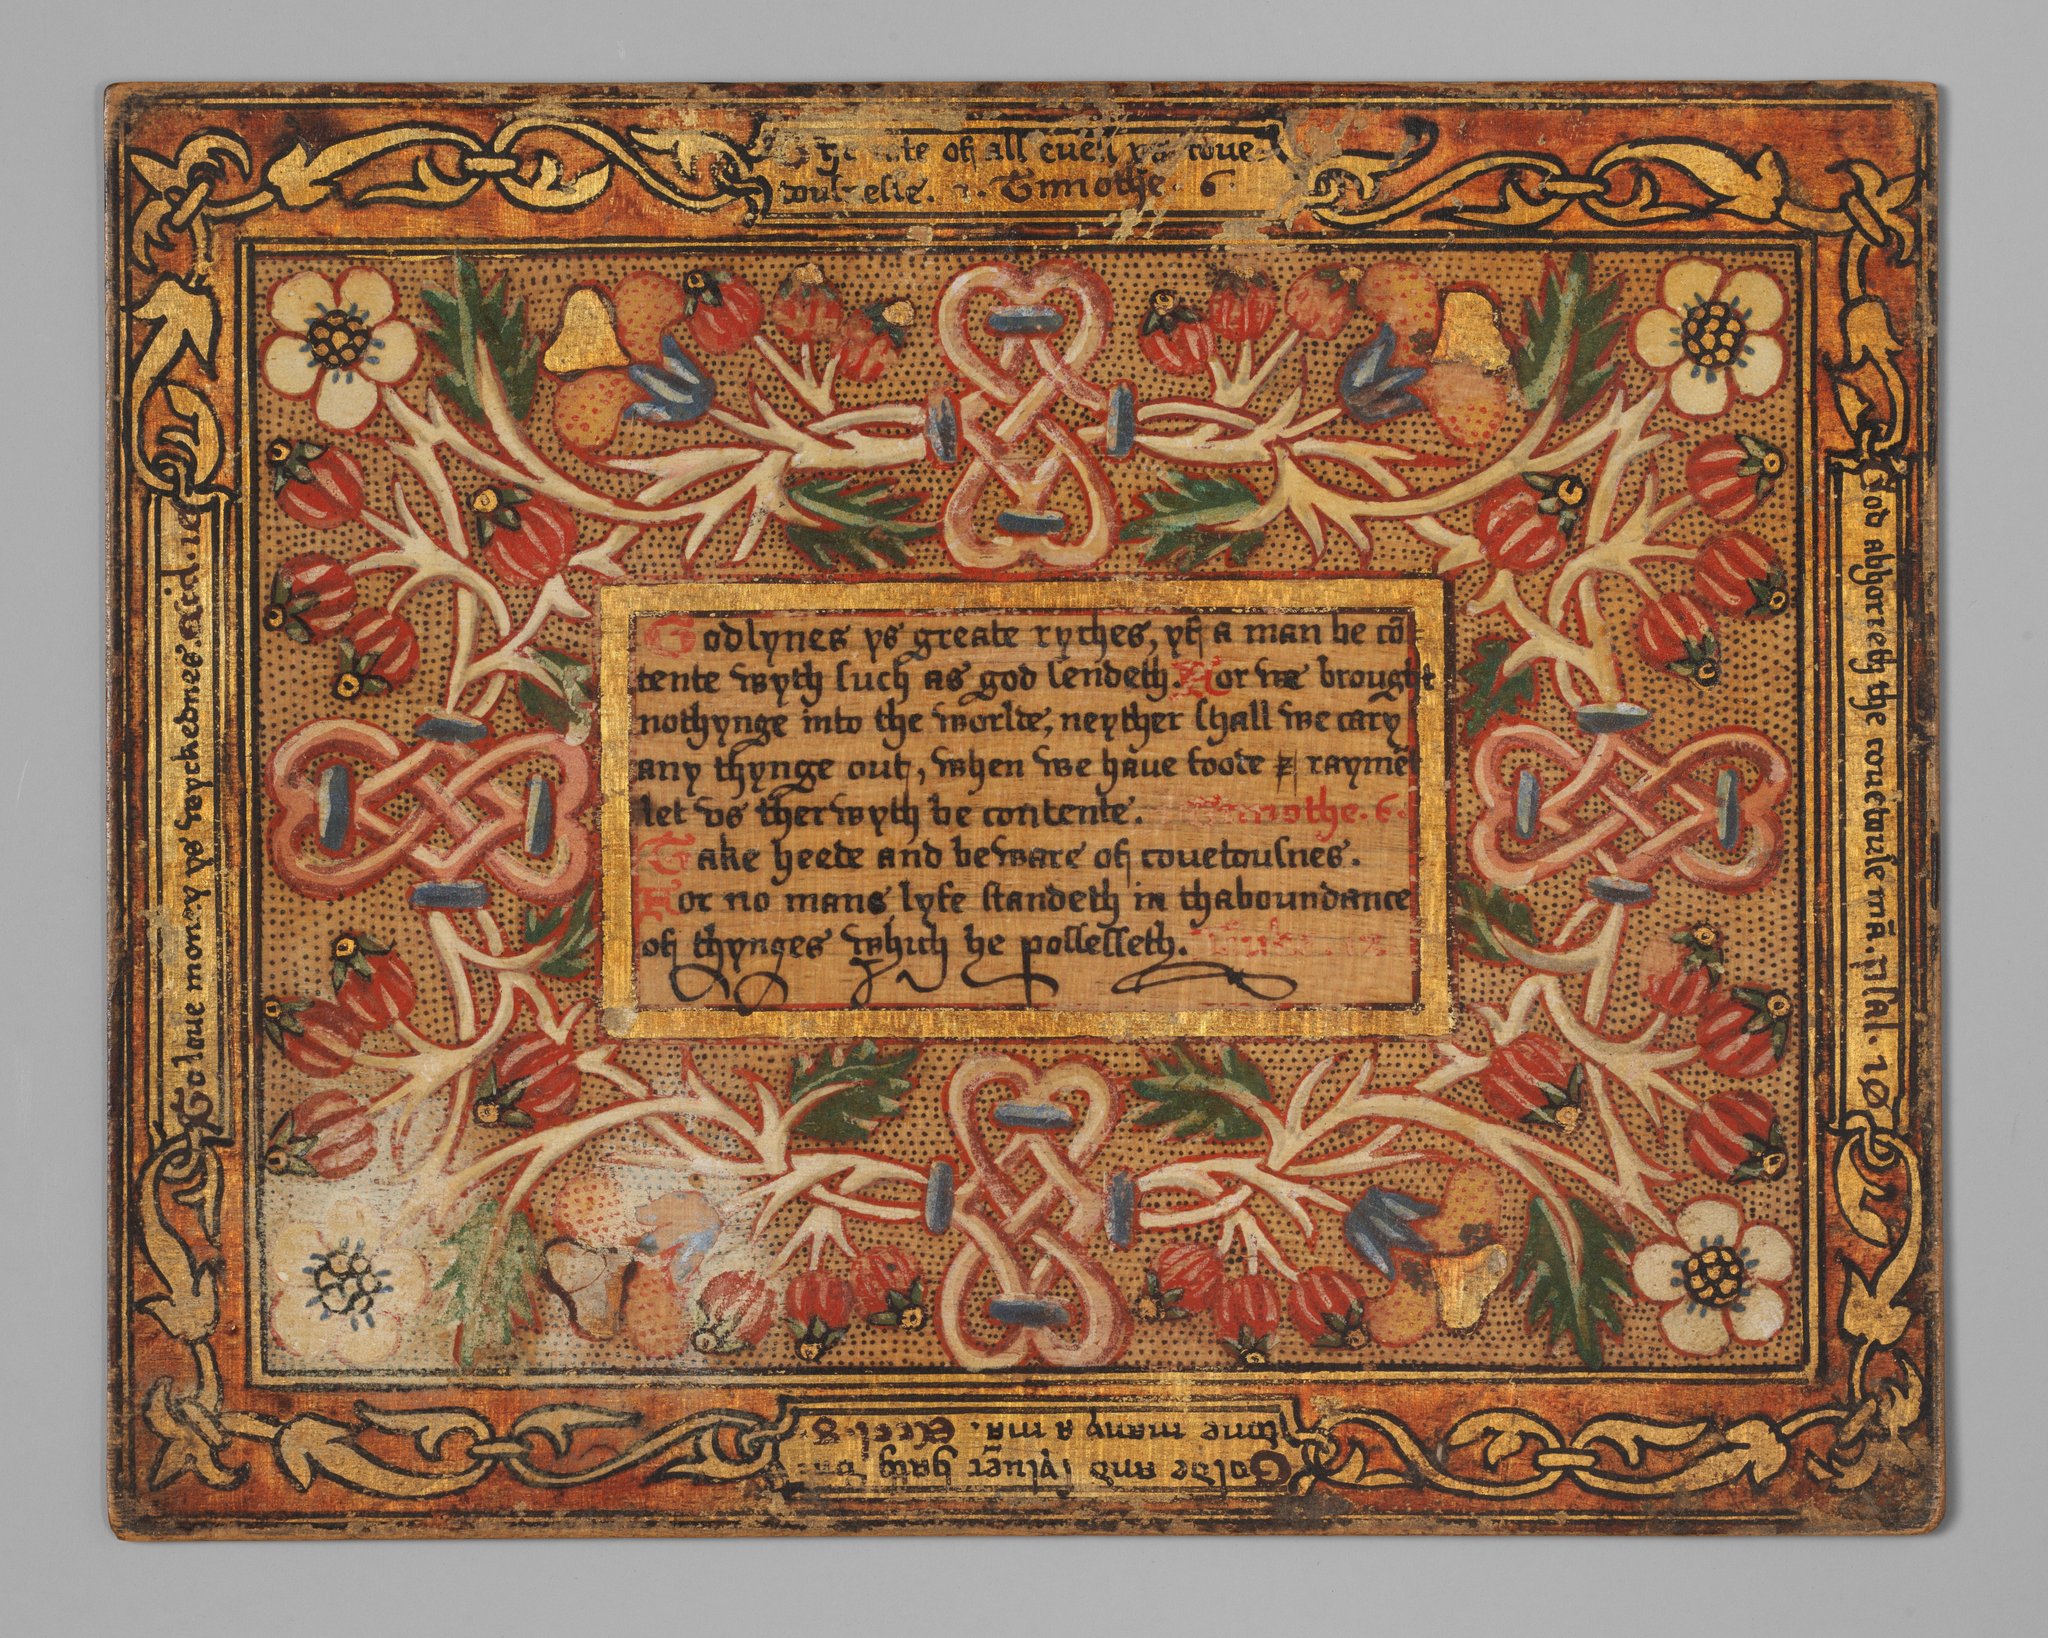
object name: trencher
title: Trencher with quotation from The Governance of Virtue (1566) (one of a set)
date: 1601-1633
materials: wood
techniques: gilding, painting